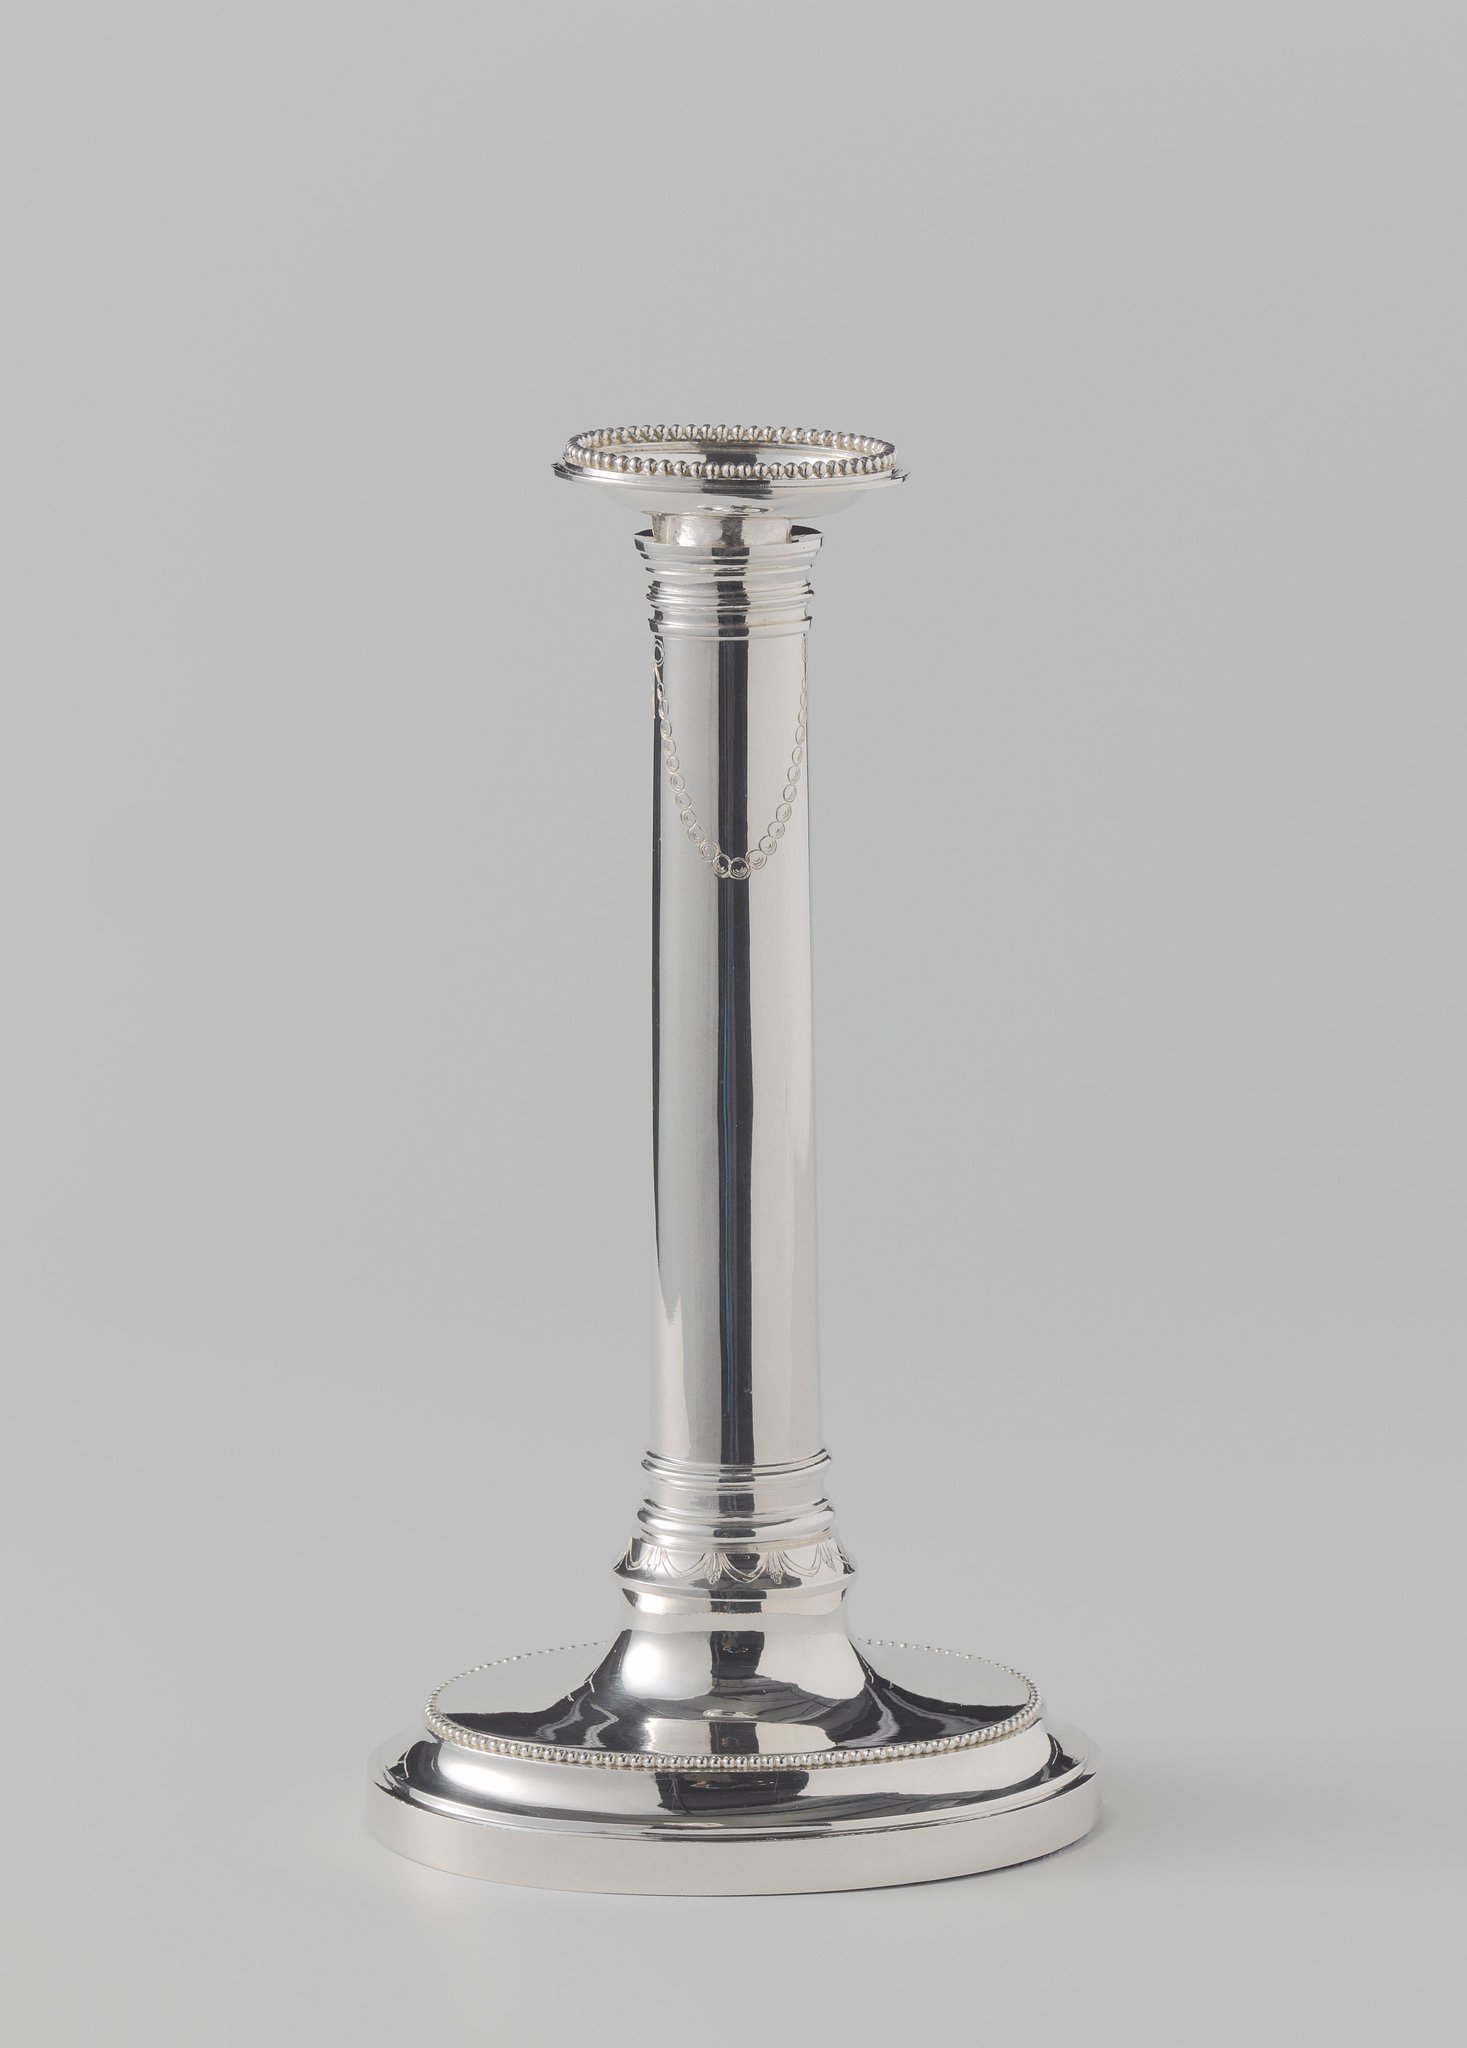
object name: candlestick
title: Kandelaar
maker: hendrik boshart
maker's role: silversmith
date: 1789-1790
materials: silver, velvet, wood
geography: middelburg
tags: voorburg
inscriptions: mark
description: Ovale kandelaar van zilver. De voet en de vetvanger versierd met een parelrand.